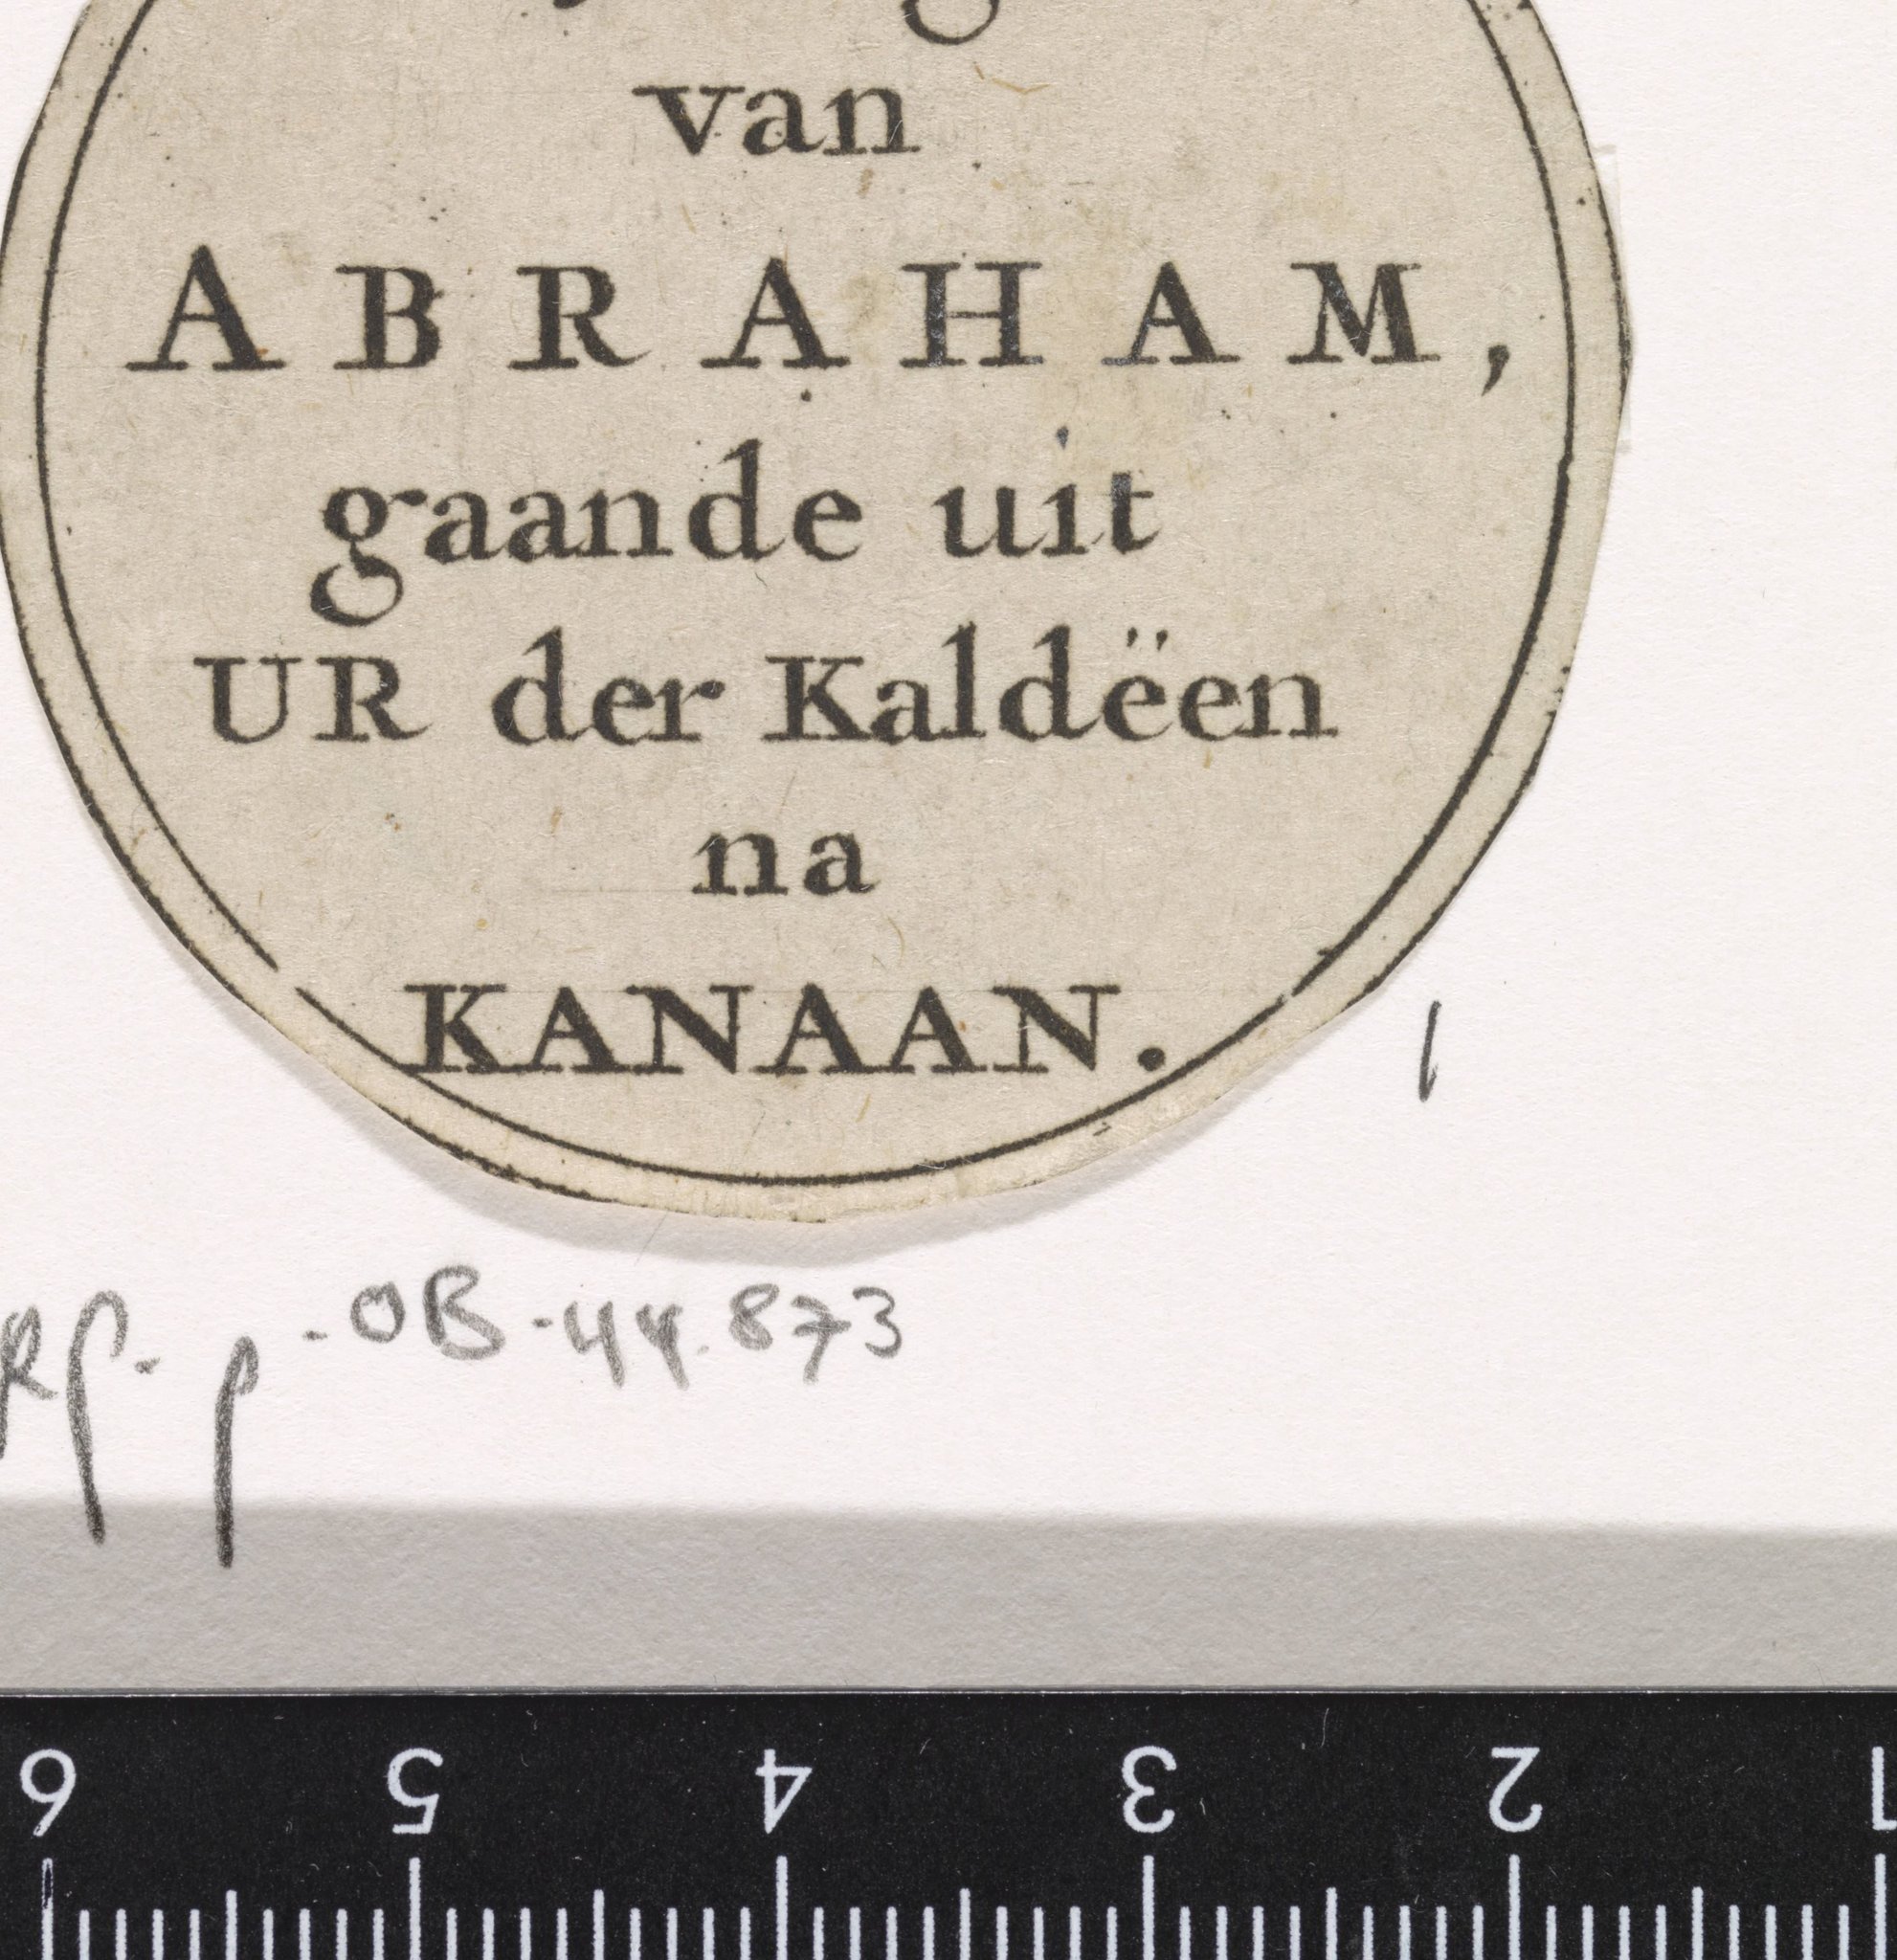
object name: text sheet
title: Tekstblad met titel: de reis van Abraham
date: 1700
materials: paper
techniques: etching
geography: amsterdam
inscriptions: collector's mark: Lugt 240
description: Boekillustratie voor Willem Goeree. Mosaize historie der Hebreeuwse kerke. Amsterdam: Willem & David Goeree, 1700.